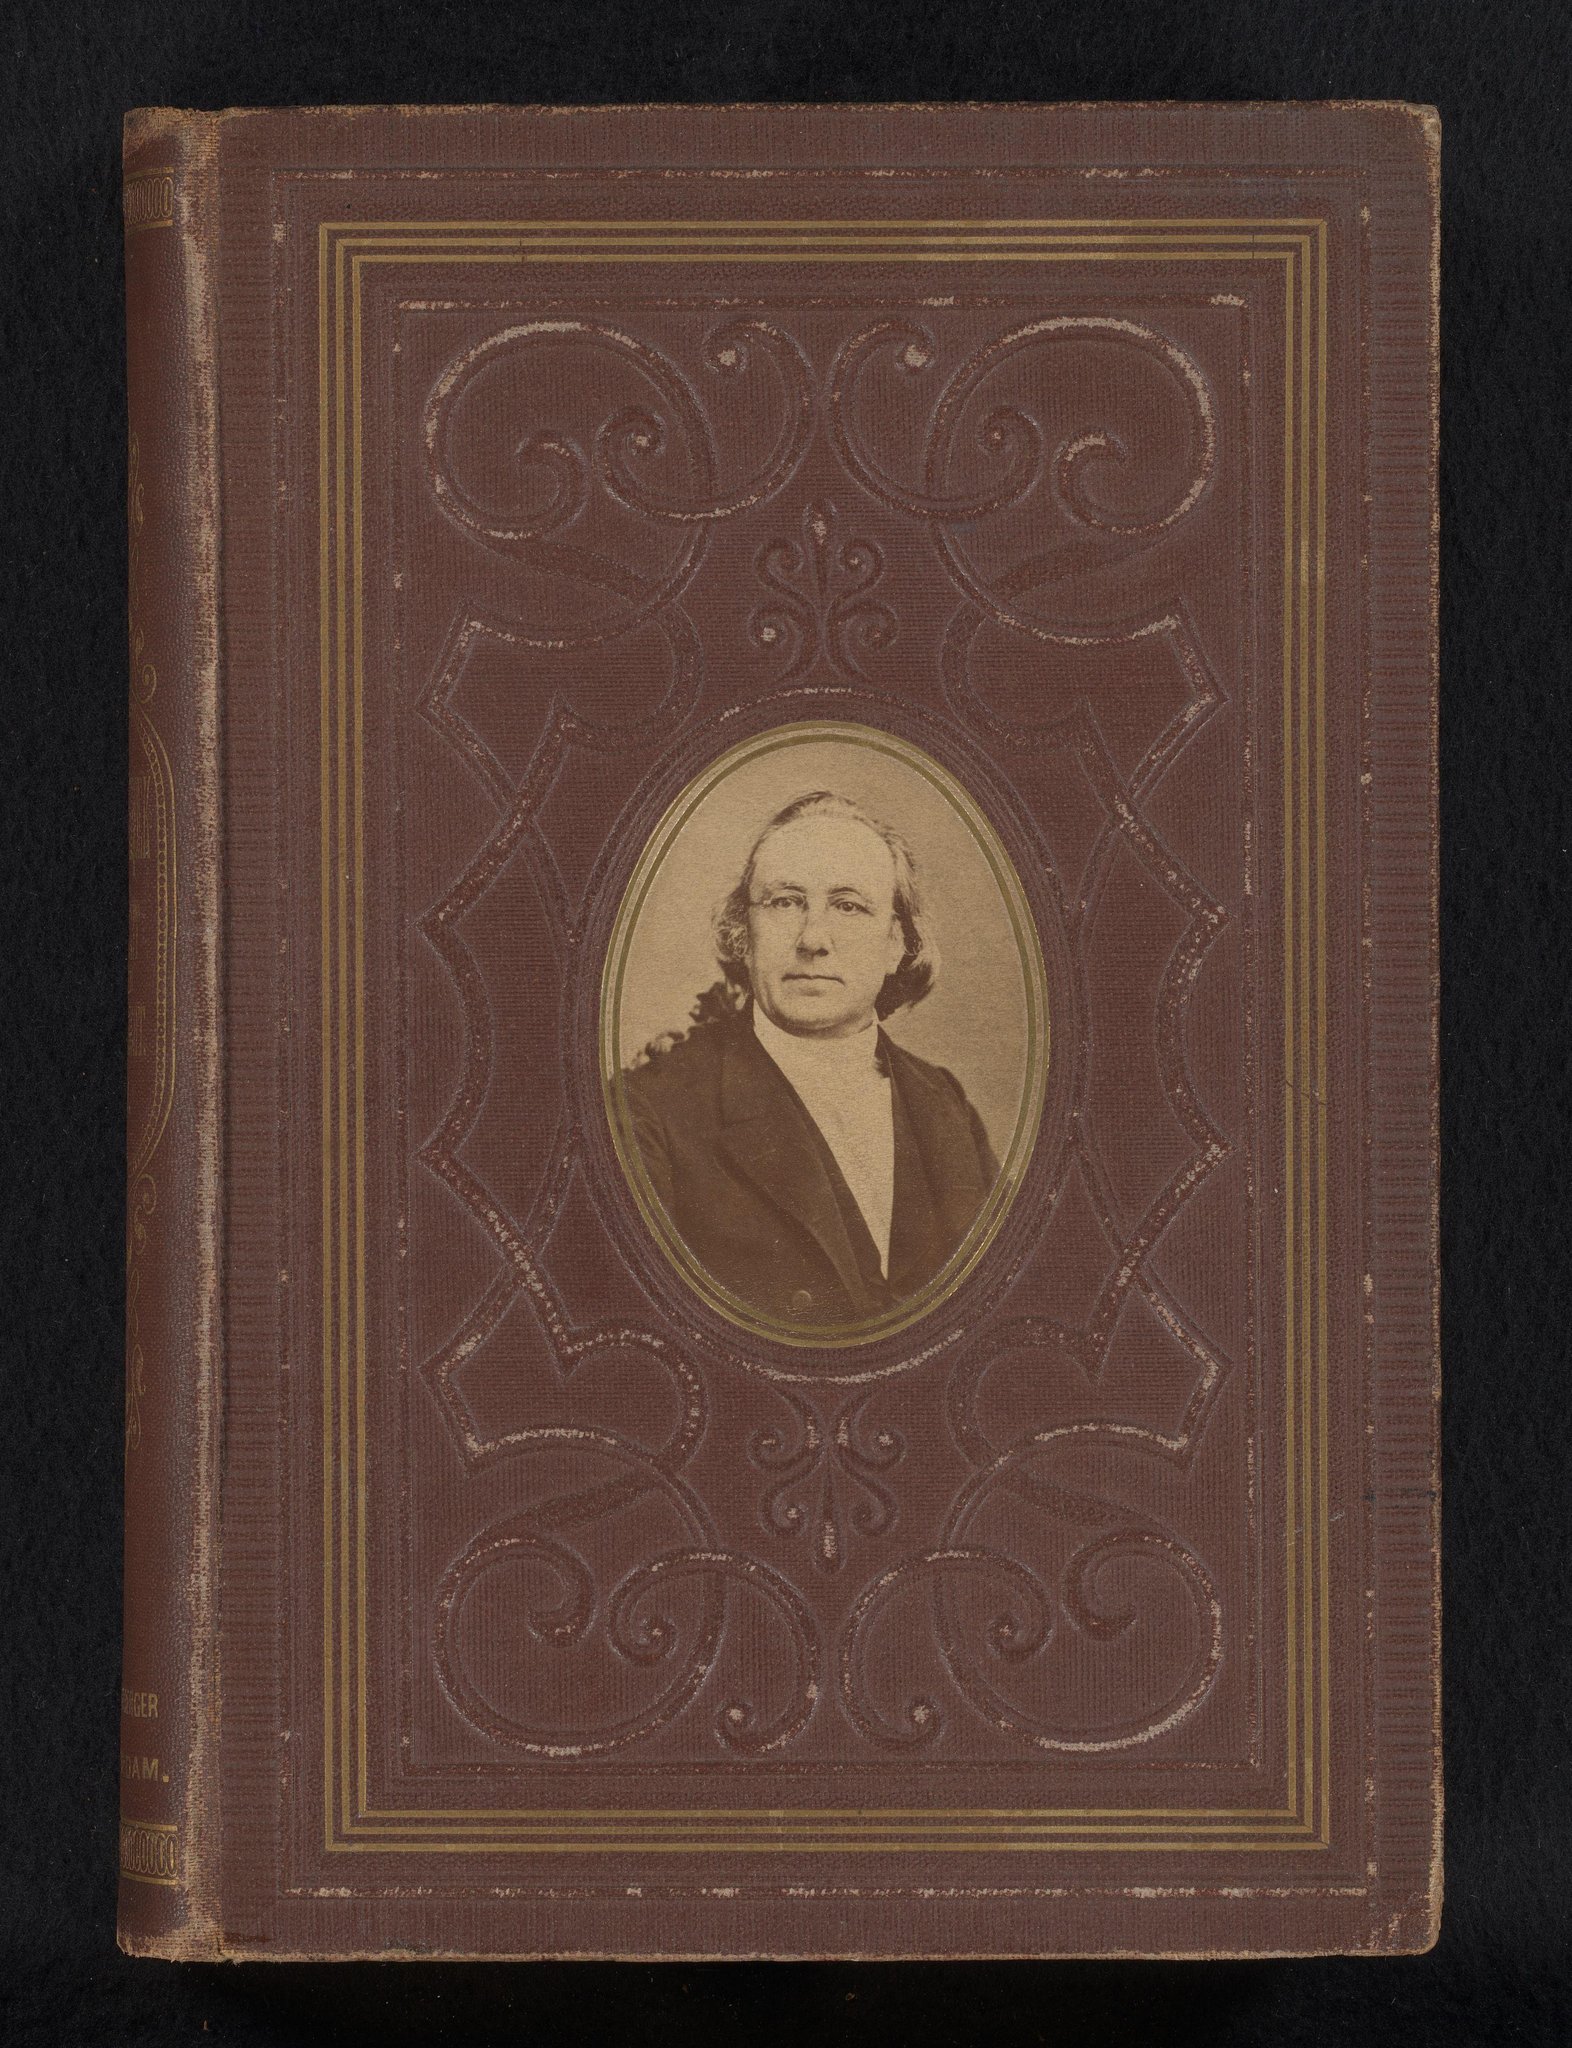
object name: photograph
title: Portret van Johannes Petrus Hasebroek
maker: Anonymous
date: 1869-1874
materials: paper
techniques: albumen print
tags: amsterdam, picture, painting